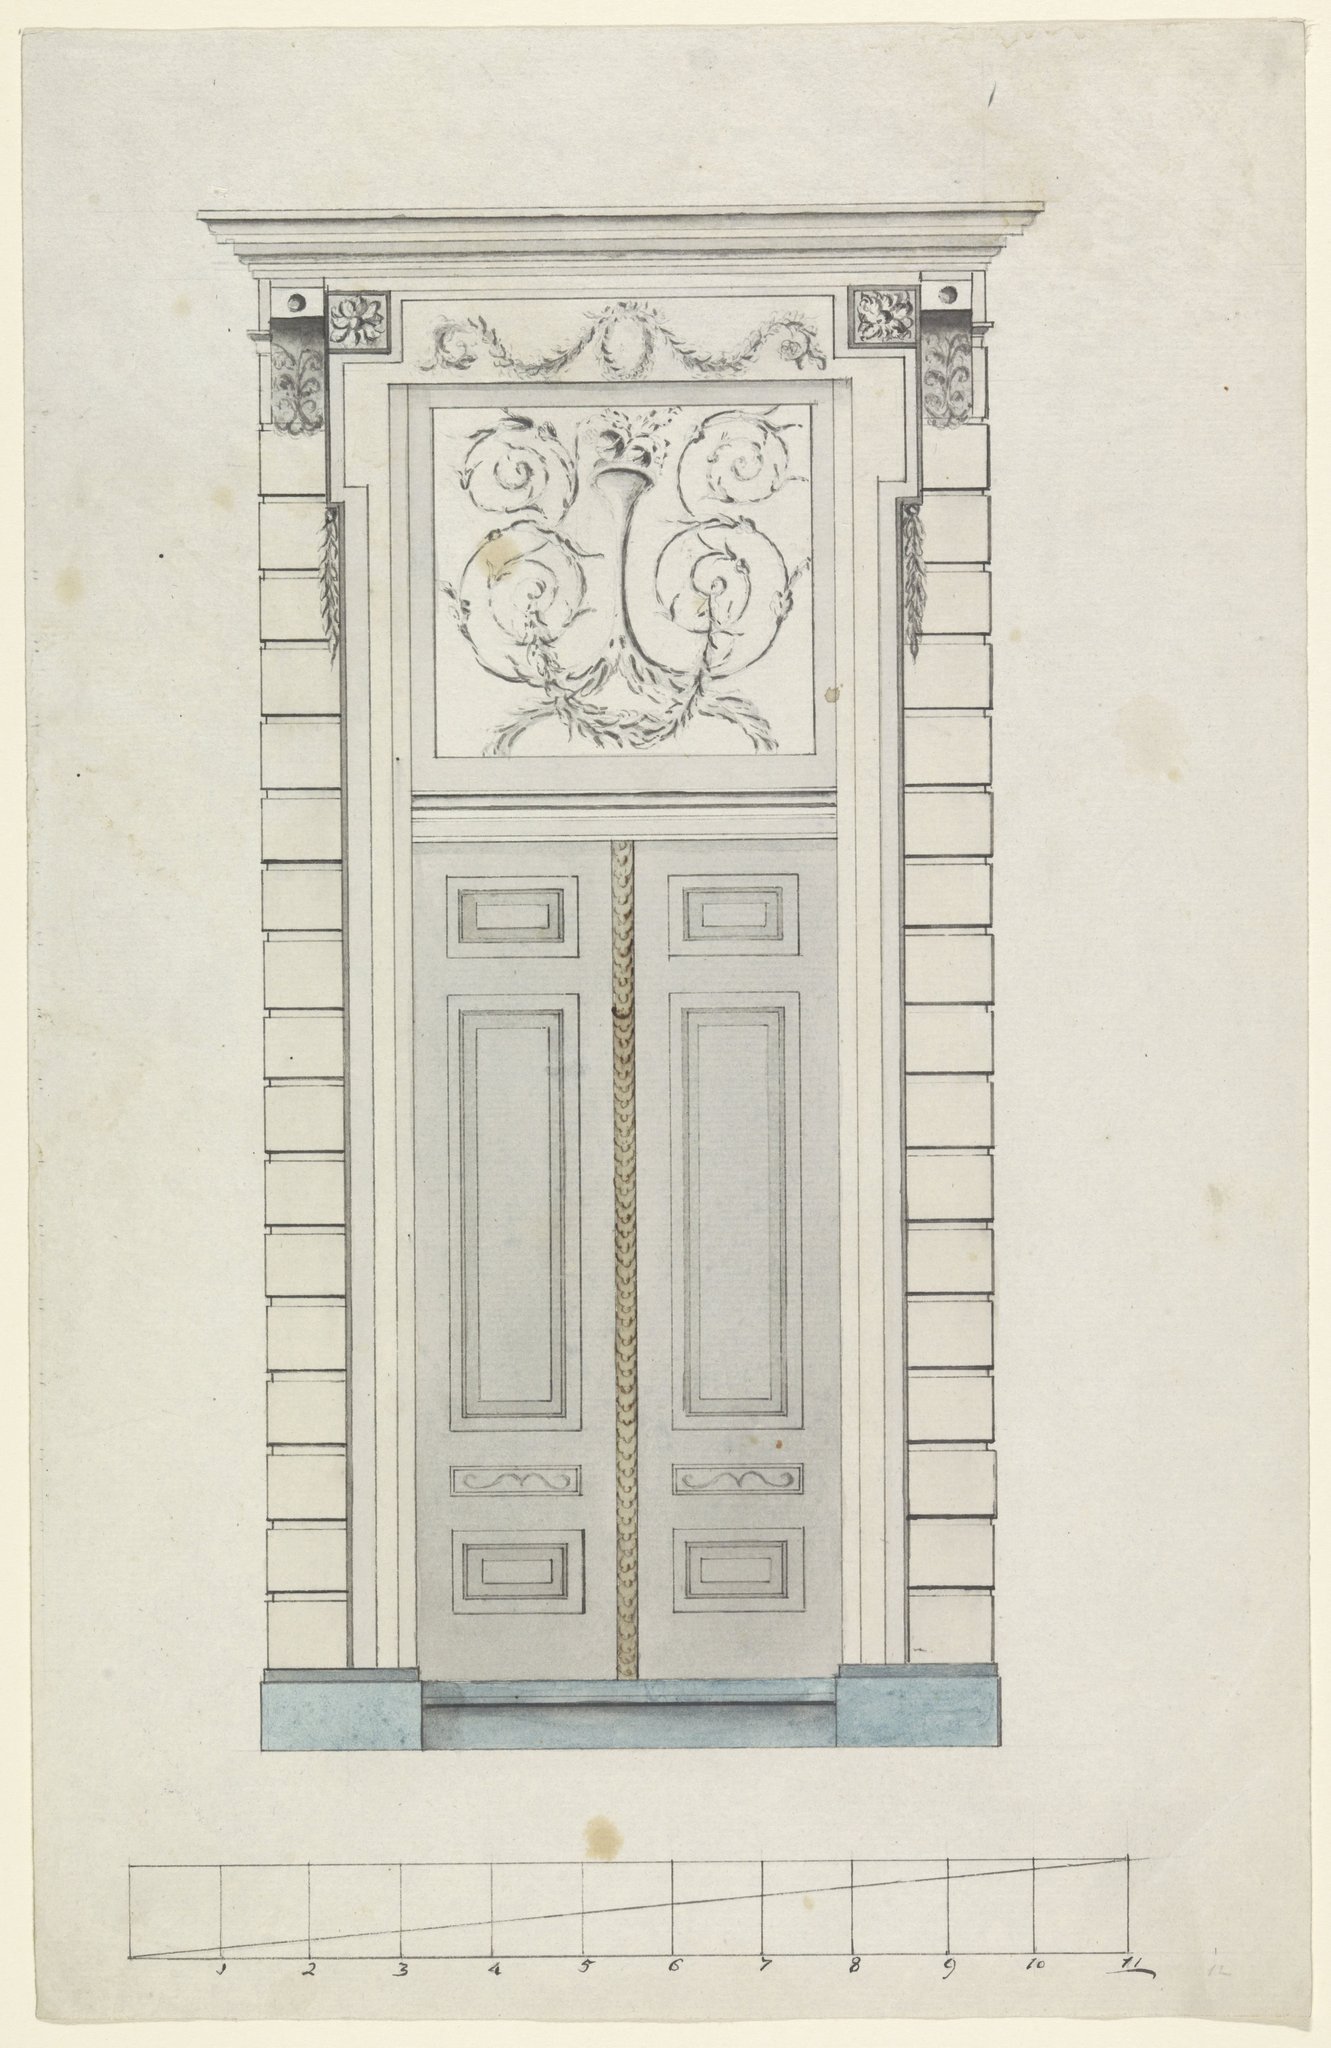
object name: ornamenttekening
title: Deur met dessus-de-porte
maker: Anonymous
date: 1650-1800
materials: ink, paper, watercolor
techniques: brush, pen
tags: door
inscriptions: collector's mark: Lugt 2228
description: Een deur met panelen en een dessus-de-porte met guirlandes en vlechtwerk.